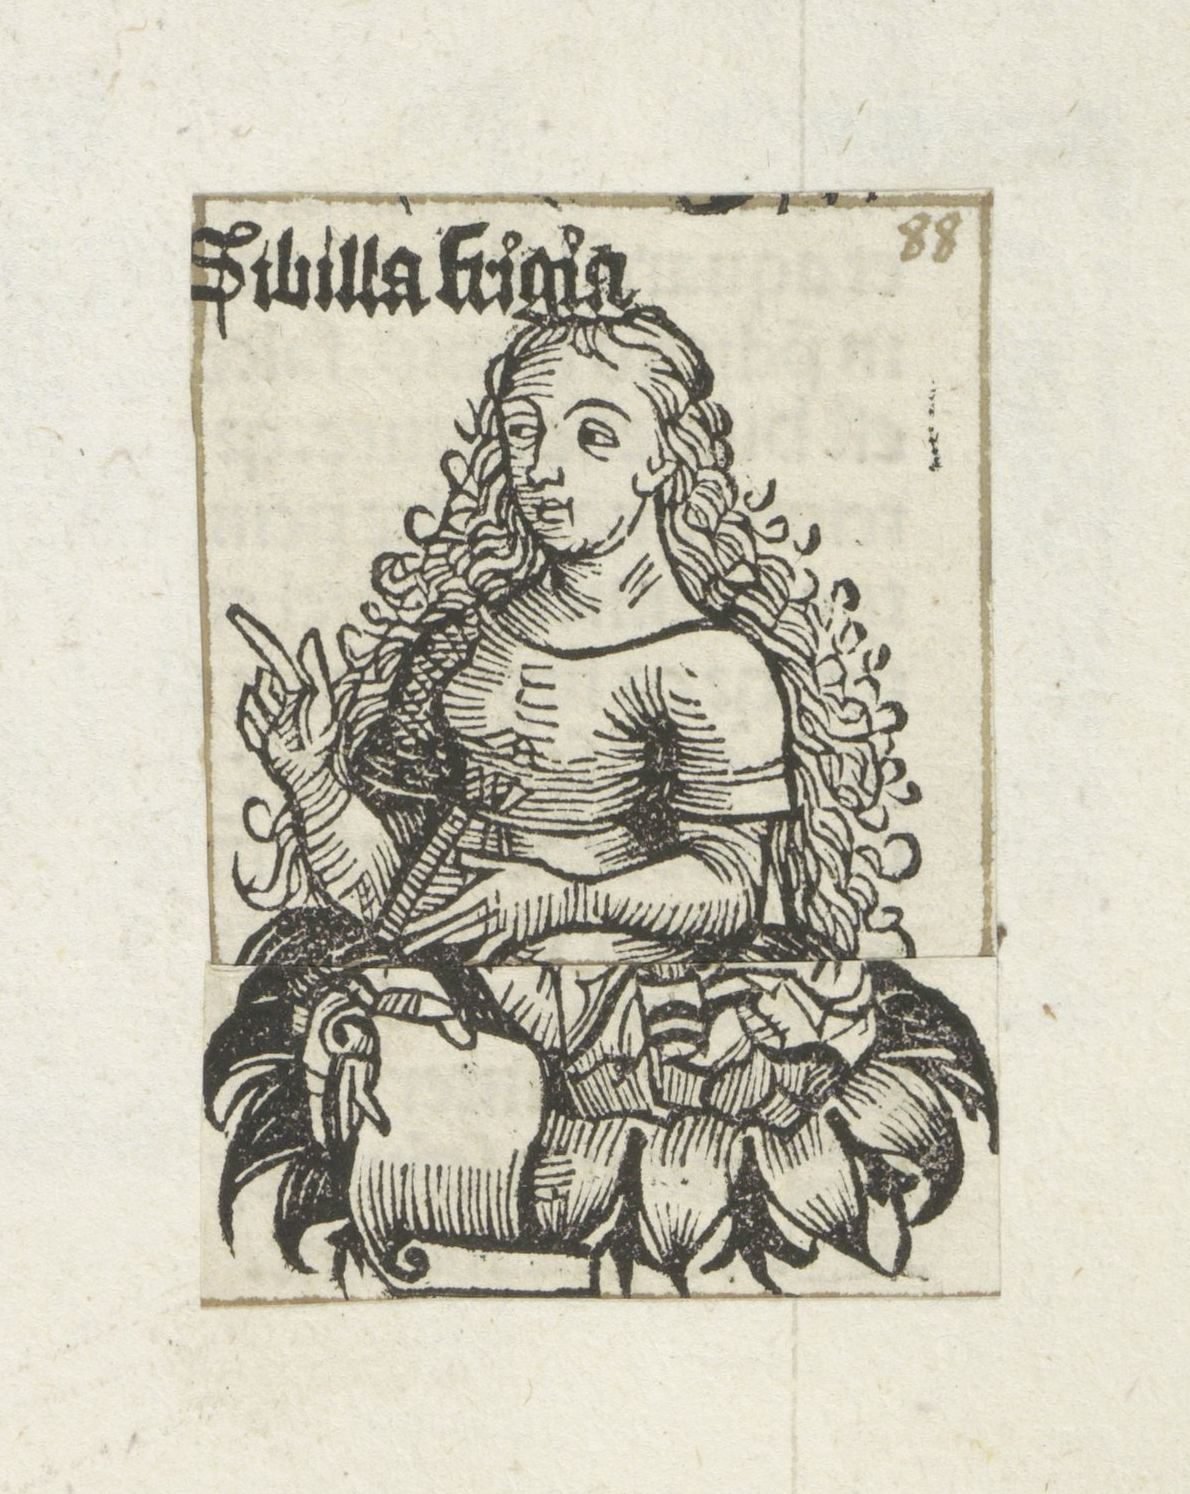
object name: album leaf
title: Sibilla Frigia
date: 1493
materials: paper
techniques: letterpress printing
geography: nuremberg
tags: sibyls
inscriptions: inscription: ‘88’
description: Een bloemkelk met een vrouw. Ze draagt haar haren los. De tekst identificeert haar als de Frygische Sibille. De onderste helft van de voorstelling betreft de afbeelding van de Europese Sibille in de Liber Chronicarum. De prent maakt deel uit van een album.